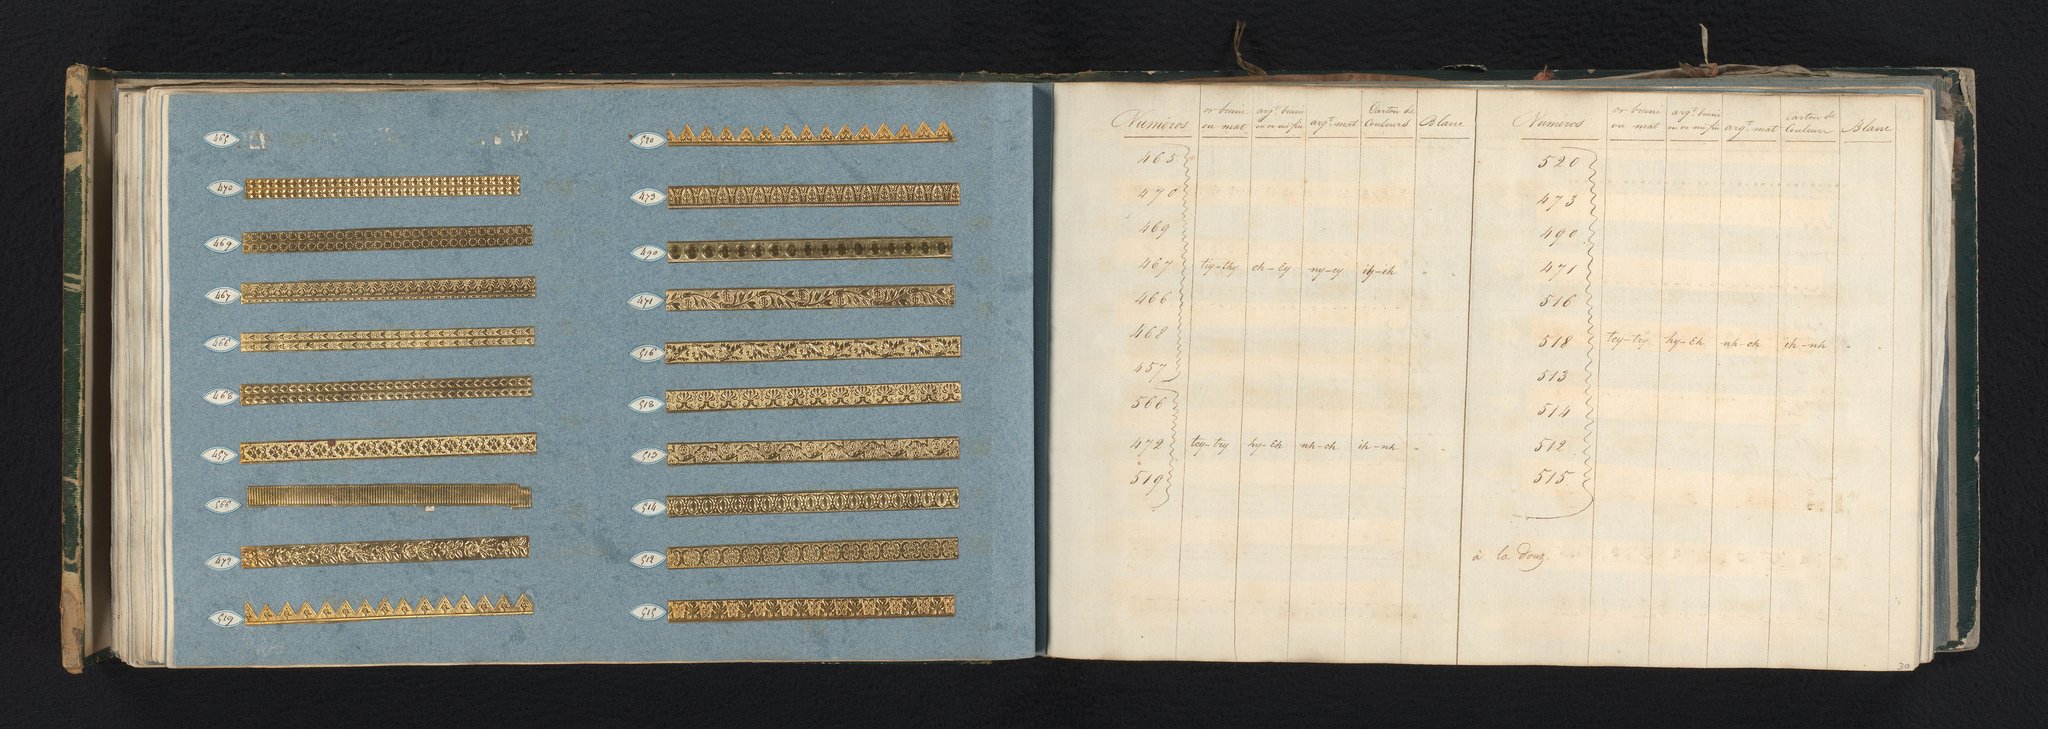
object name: manuscript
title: Twee bladzijden met stalen van sierlijsten van goudkleurig metaalpapier en bijbehorend tabel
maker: Anonymous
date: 1830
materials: gold leaf, ink, paper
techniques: manufacturing, writing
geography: france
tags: ornaments ~ art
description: Twee bladzijden met links 19 opgeplakte en met etiketten genummerde (465-515) stalen van eenvoudig gedecoreerde sierlijsten van goudkleurig metaalpapier (staal nr. 465 ontbreekt). Op de tegenoverliggende rechterbladzijde een tabel met de handgeschreven corresponderende specificaties (in code) per ornament. Onderdeel van het stalenboek geschonken door de dames Van Rijn, vermoedelijk van een Franse papierfabrikant van luxe papieren, of diens vertegenwoordiger in Nederland, ca. 1830.